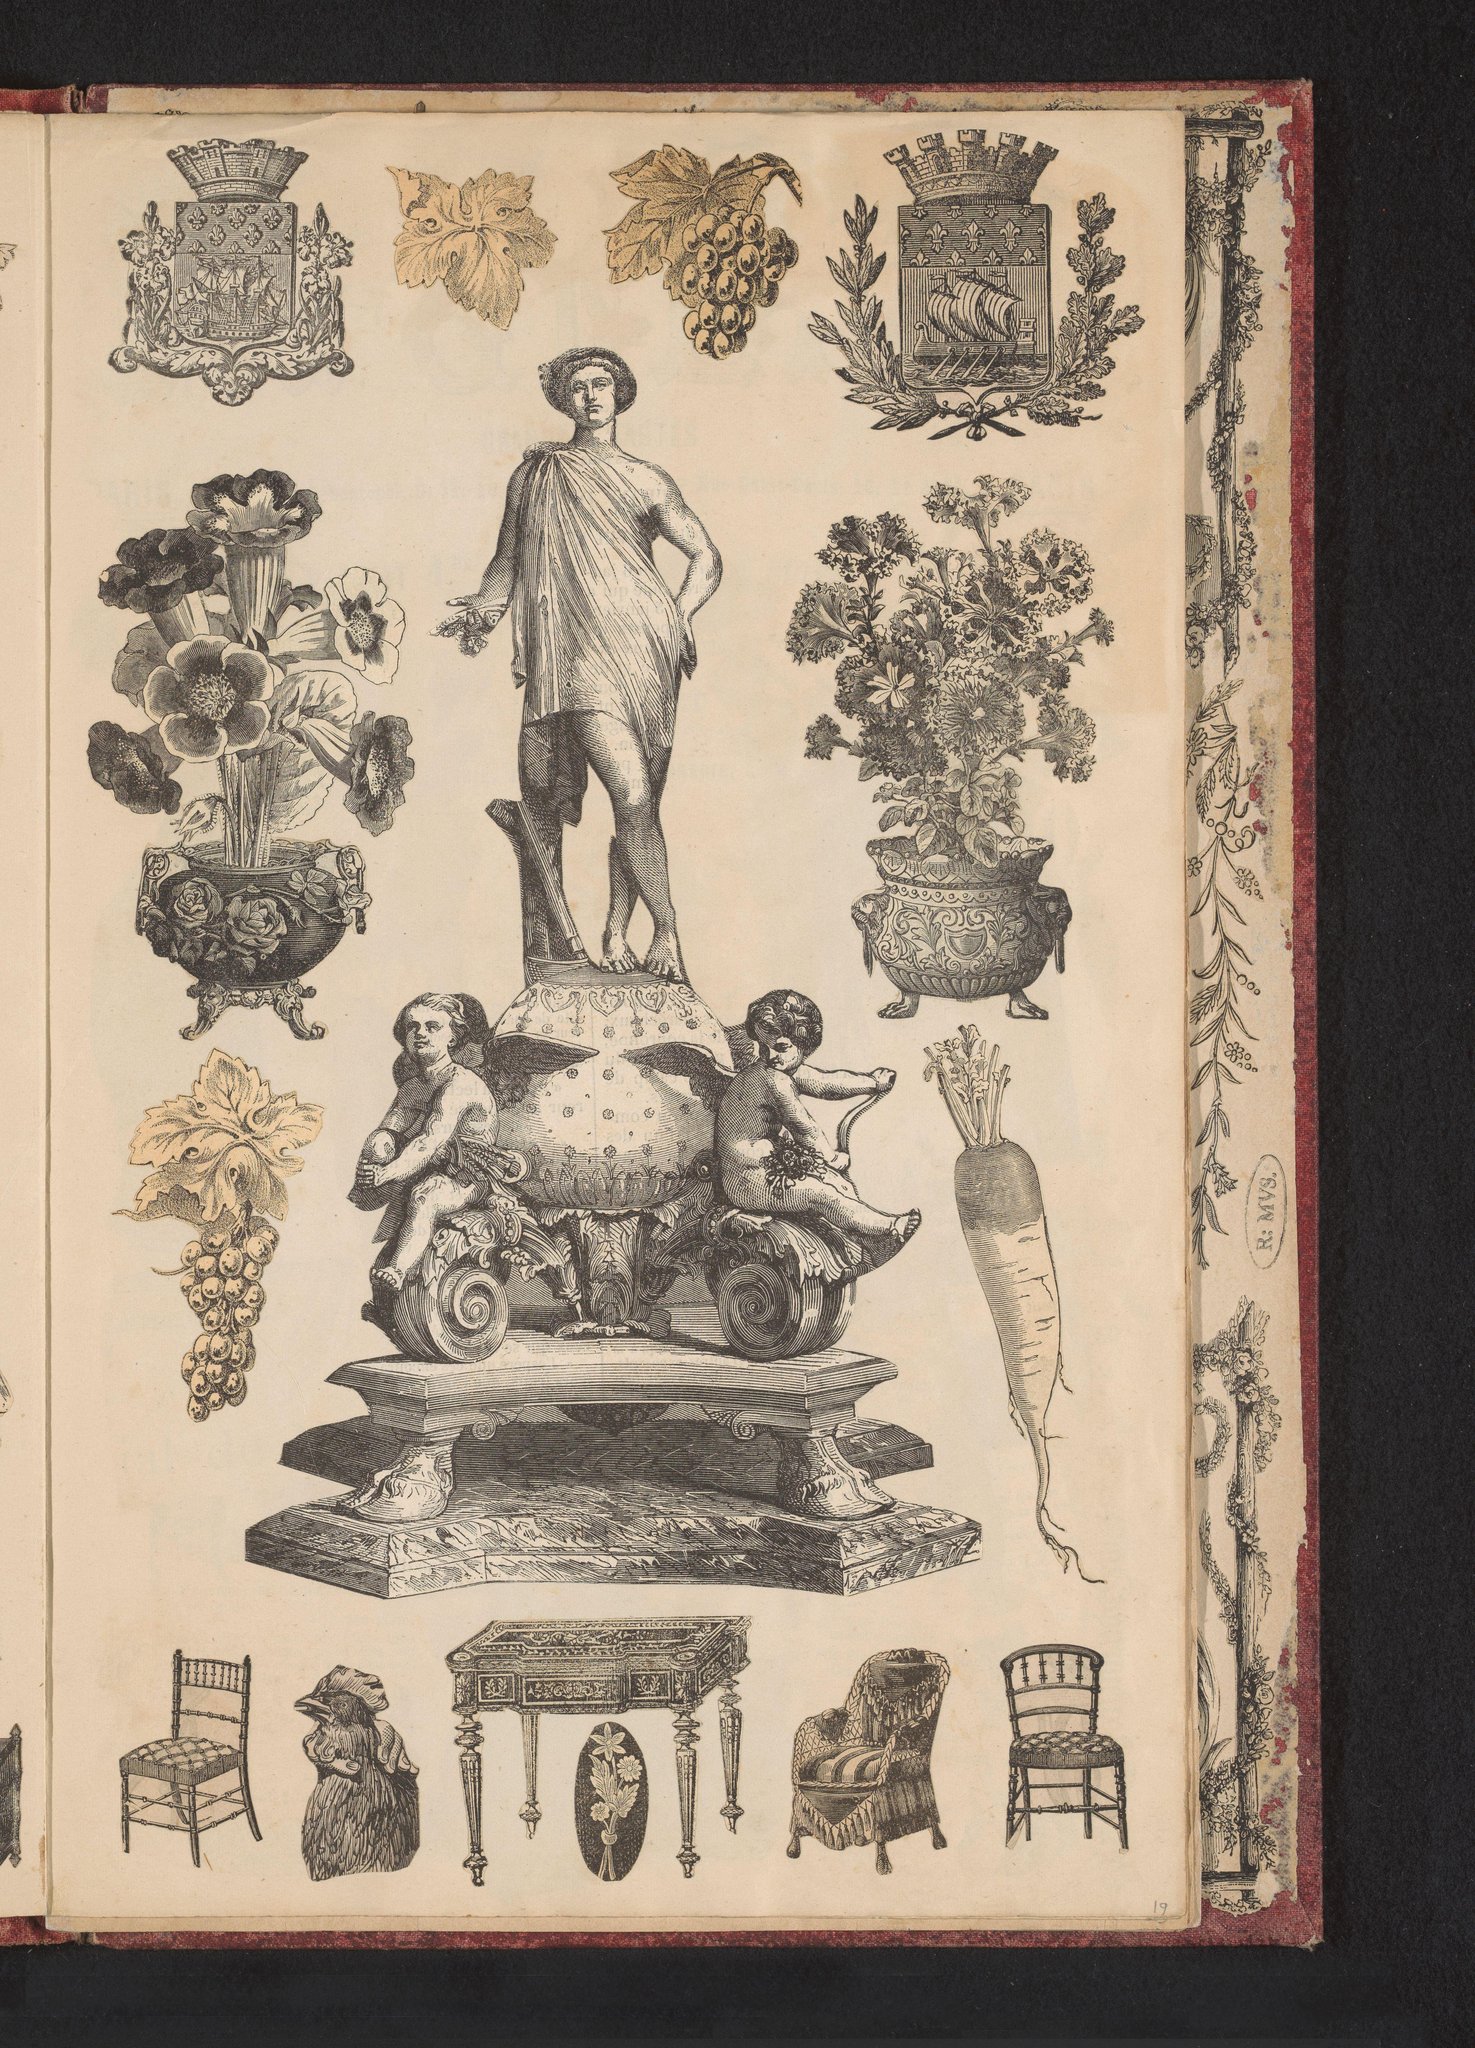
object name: collage visual work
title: Collage van uitgeknipte prenten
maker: Anonymous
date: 1870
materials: paper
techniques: engraving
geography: paris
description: Collage van uitgeknipte prenten. Onderdeel van een album met 32 bladen, aan beide zijden beplakt met uitgeknipte prenten, vermoedelijk afkomstig uit 19e-eeuwse tijdschiften.